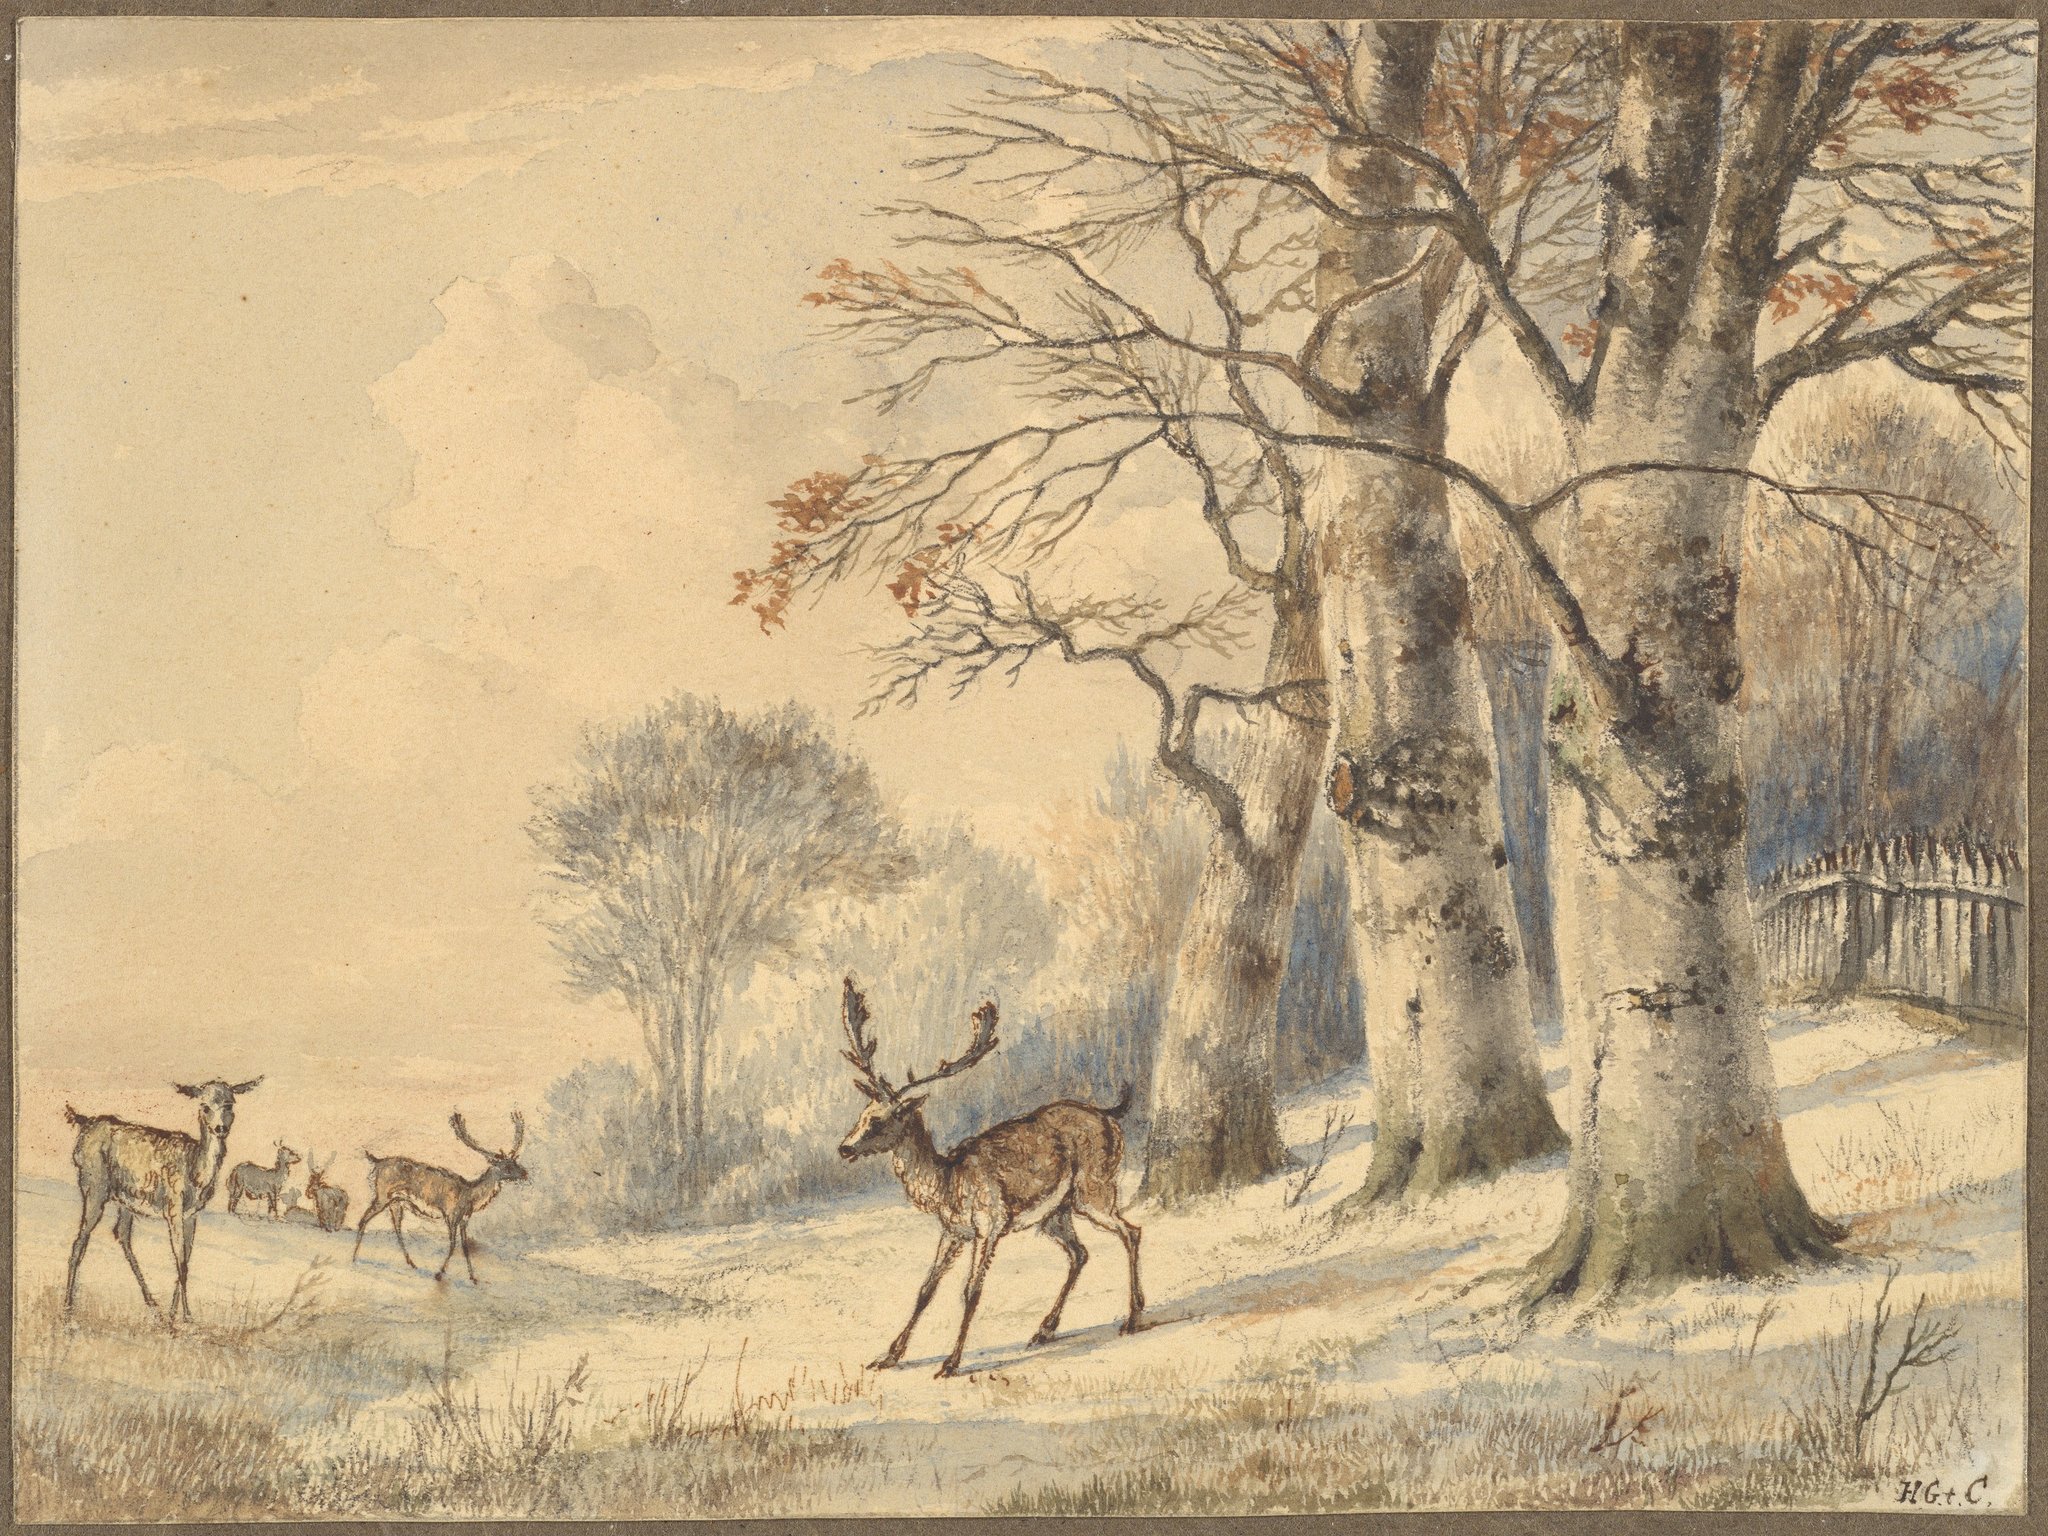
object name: drawing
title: Deer under Beech Trees in Summer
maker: hendrik gerrit ten cate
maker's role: artist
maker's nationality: dutch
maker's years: 1803-1856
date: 1853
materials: chalk, graphite, watercolor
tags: deer,trees,summer